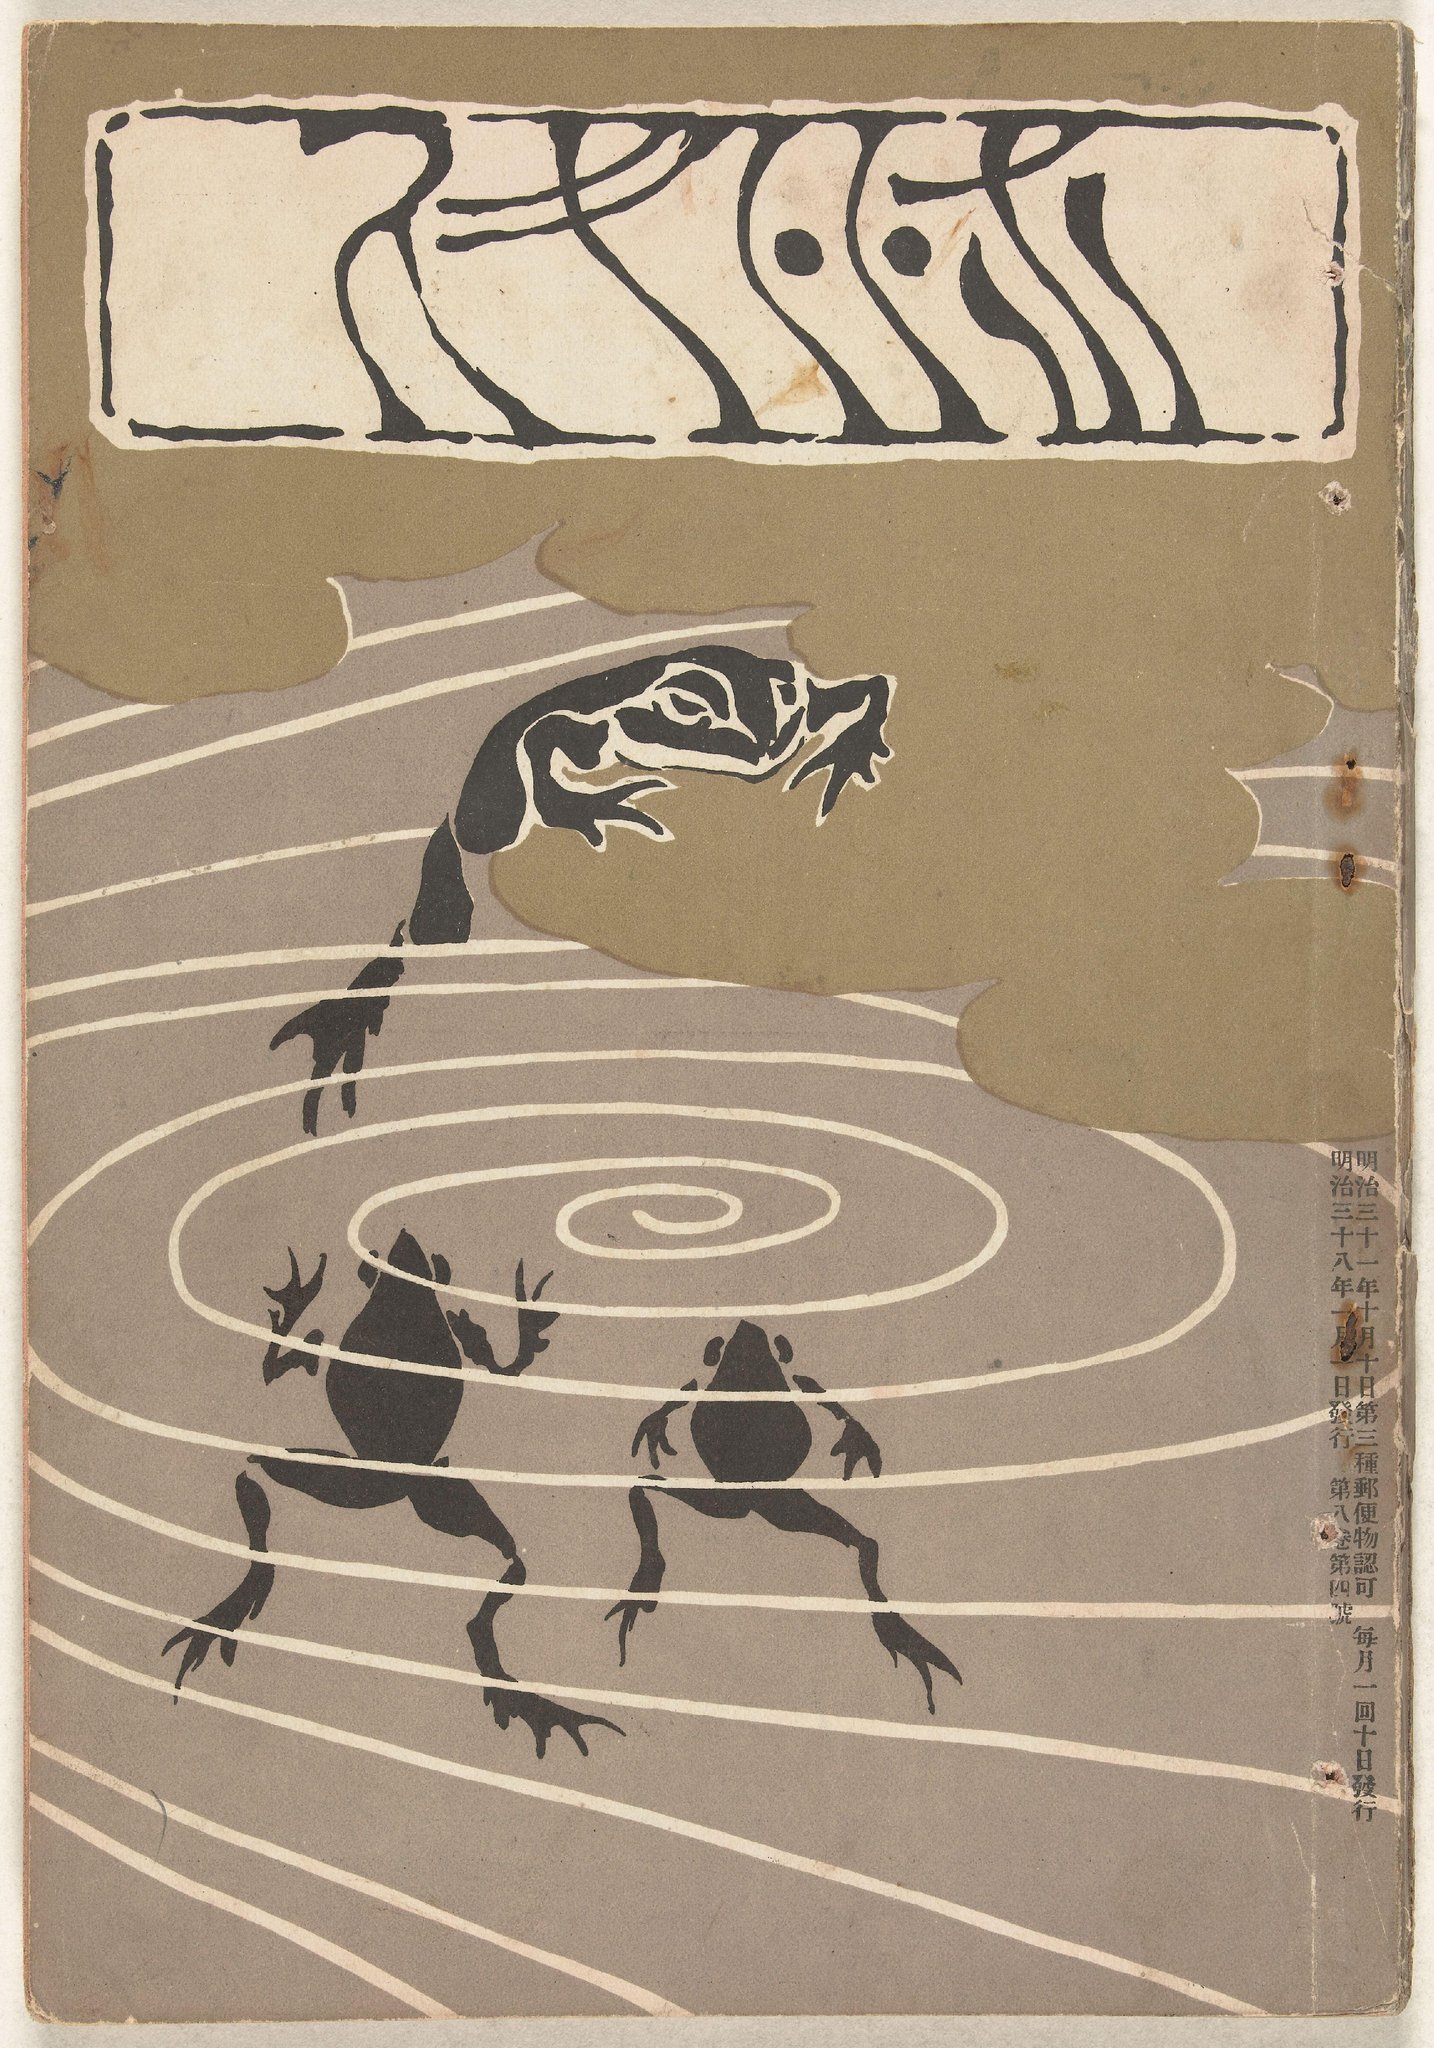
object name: book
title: Januari 1905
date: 1905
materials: paper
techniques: woodcut, letterpress printing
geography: japan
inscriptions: date